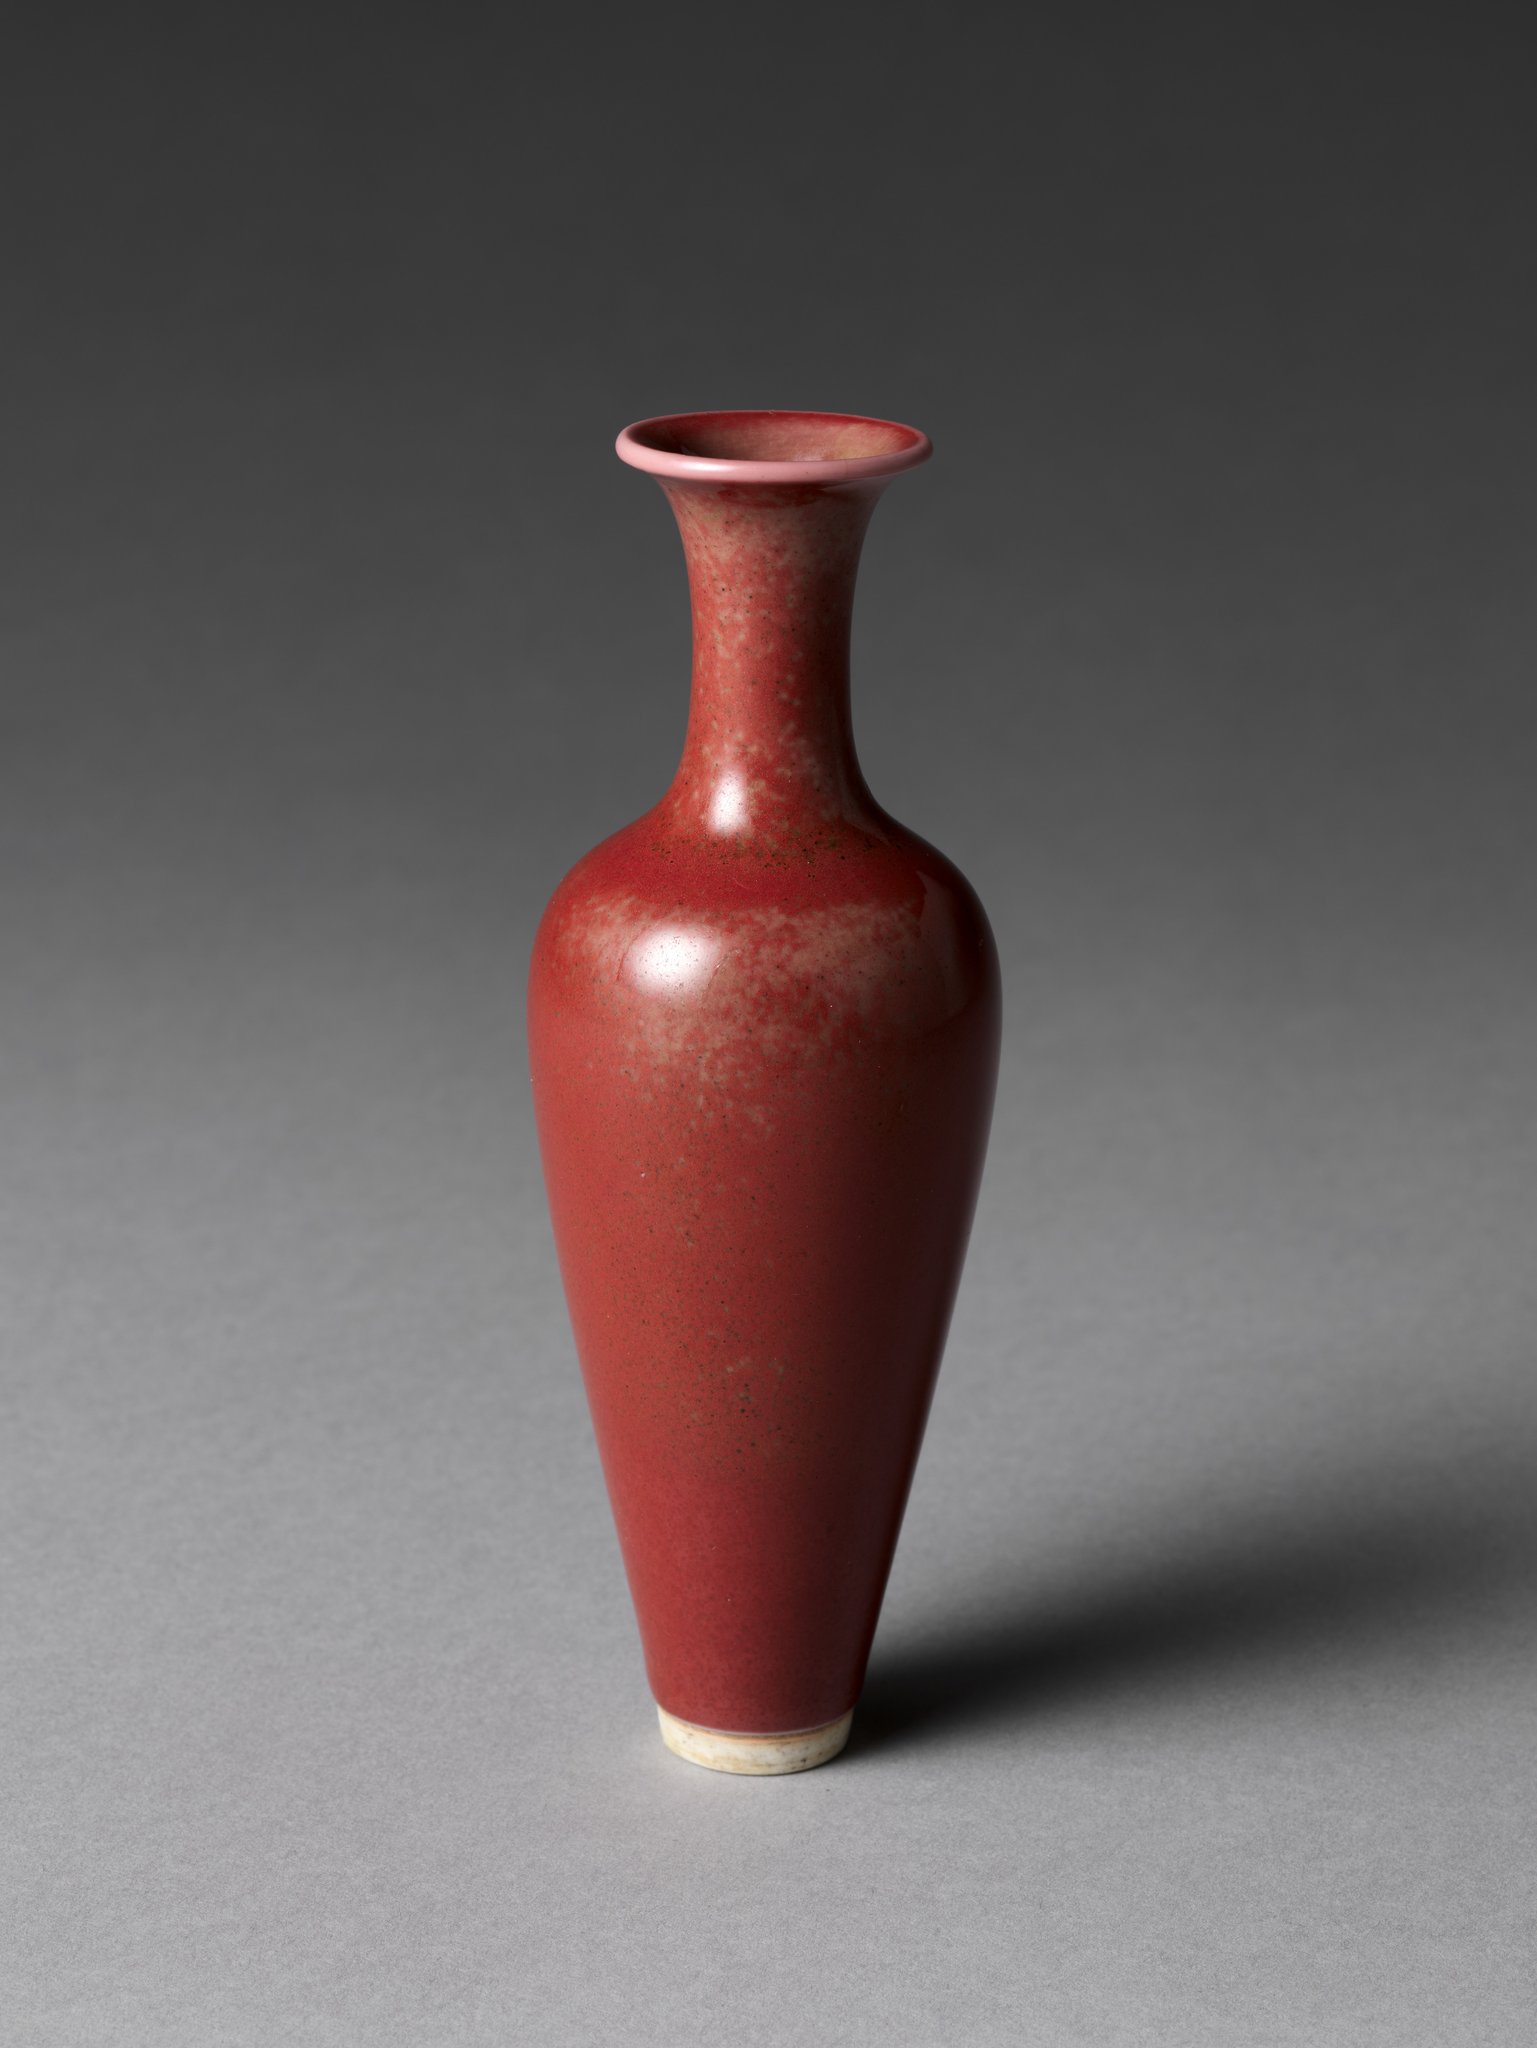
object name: vase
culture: chinese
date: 1667-1733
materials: glaze, porcelain